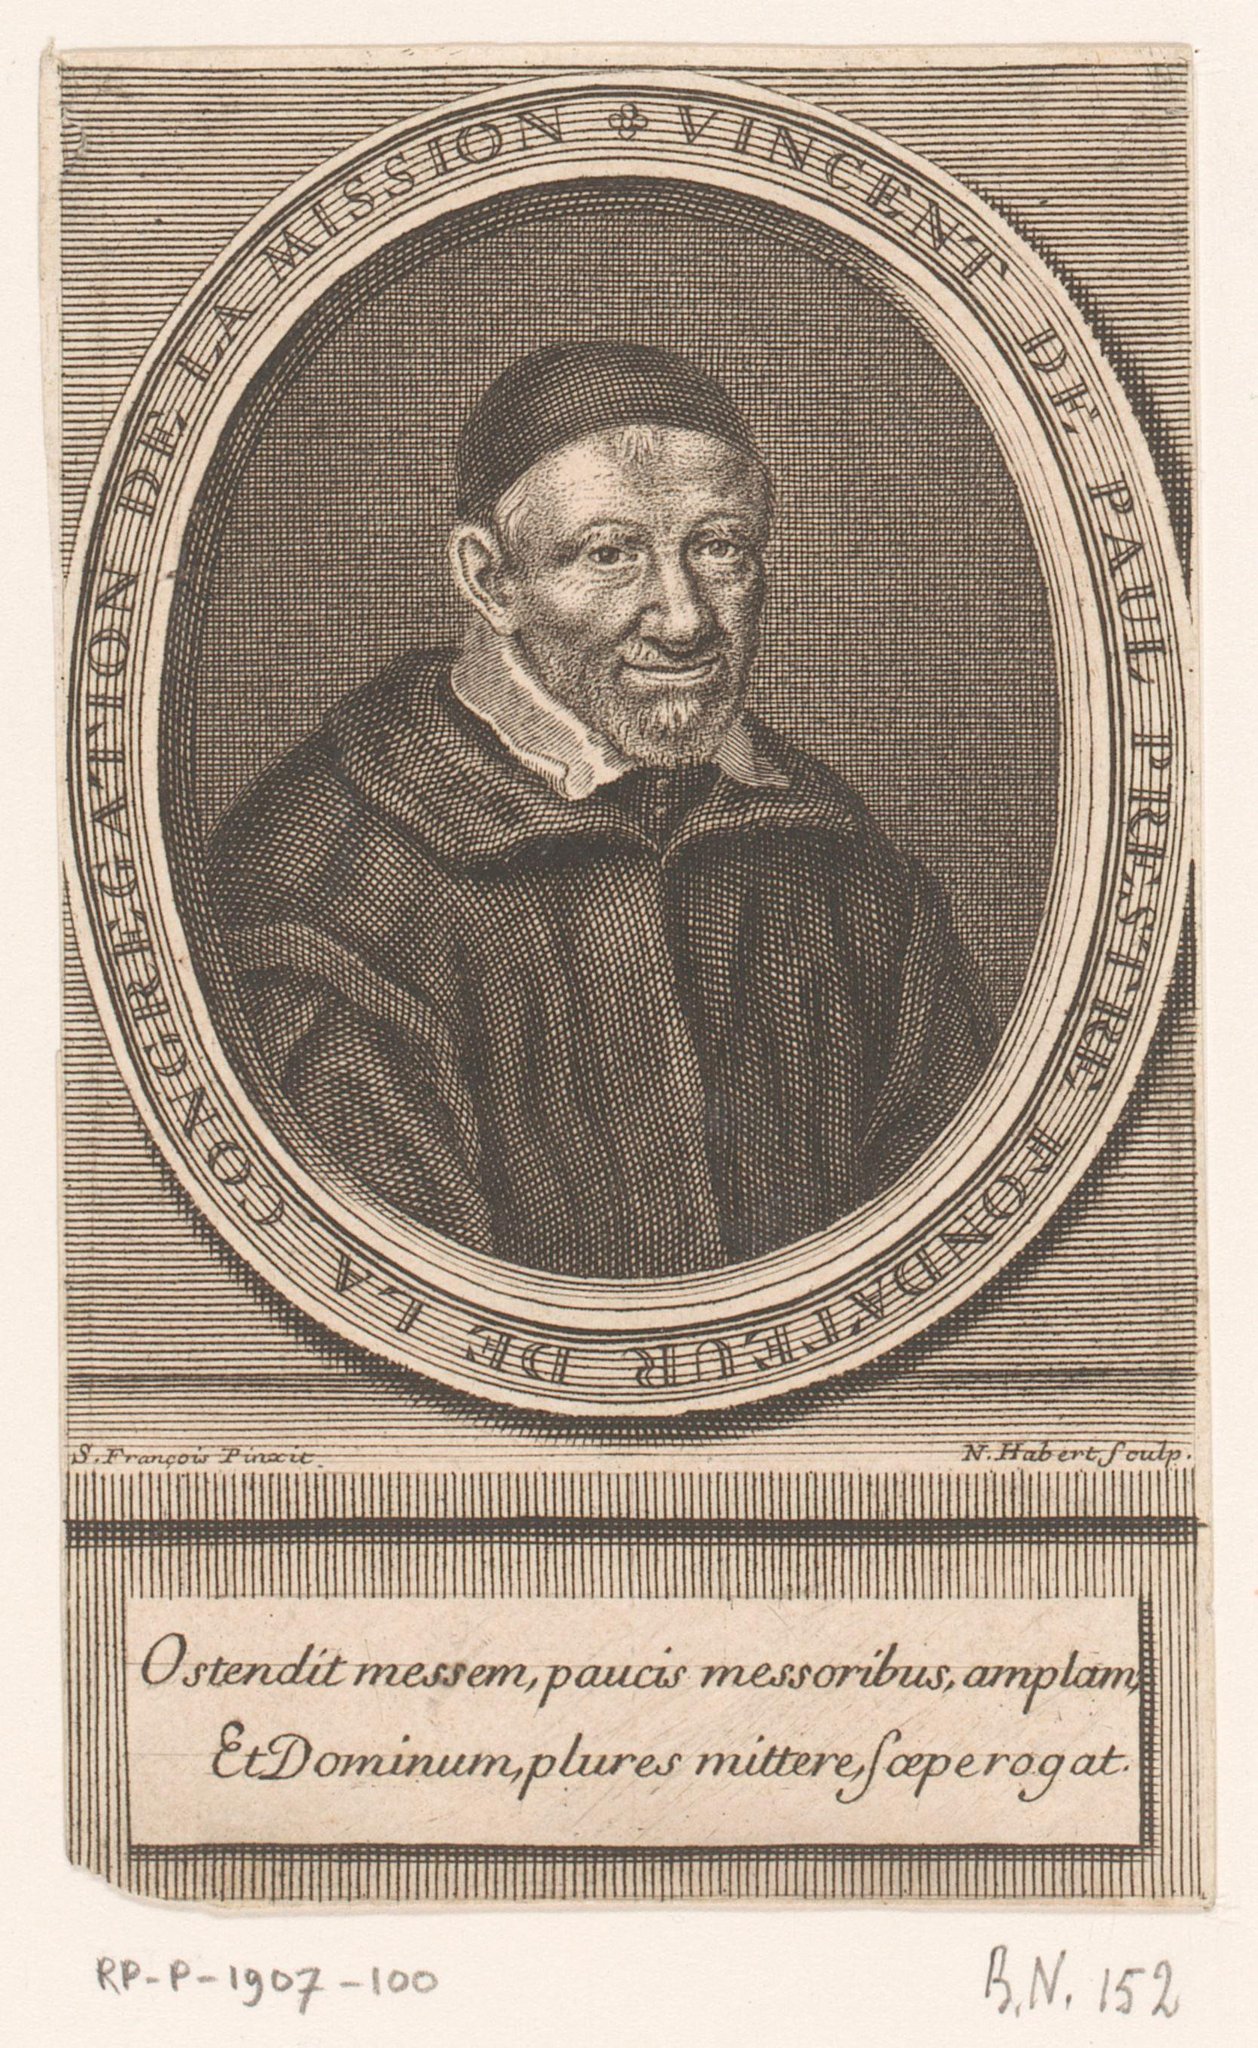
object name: print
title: Portret van Vincent de Paul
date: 1660-1715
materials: paper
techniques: engraving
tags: priest, priest (roman catholic), historical persons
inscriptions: collector's mark: Lugt 2228